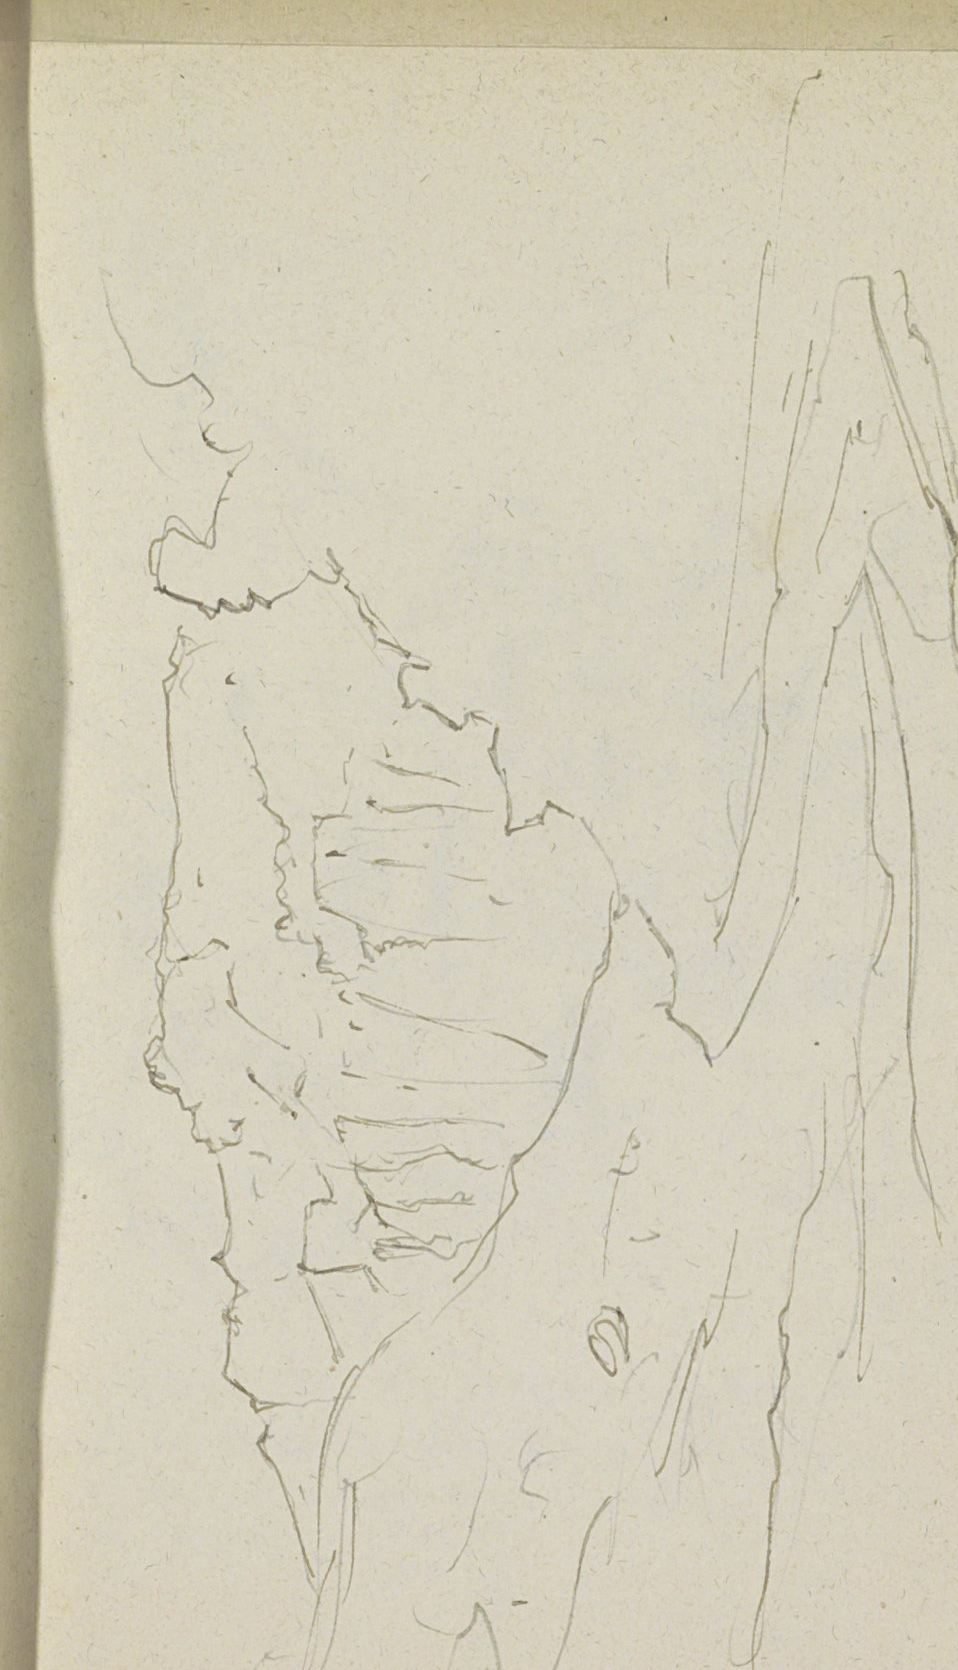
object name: sketchbook leaf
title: Berglandschap met rotsen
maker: johannes tavenraat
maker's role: draughtsman, painter, print maker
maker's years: 1809-1881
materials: ink, paper, pencil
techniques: pen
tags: rocks, mountains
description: Blad 21 recto uit een schetsboek met 88 bladen.